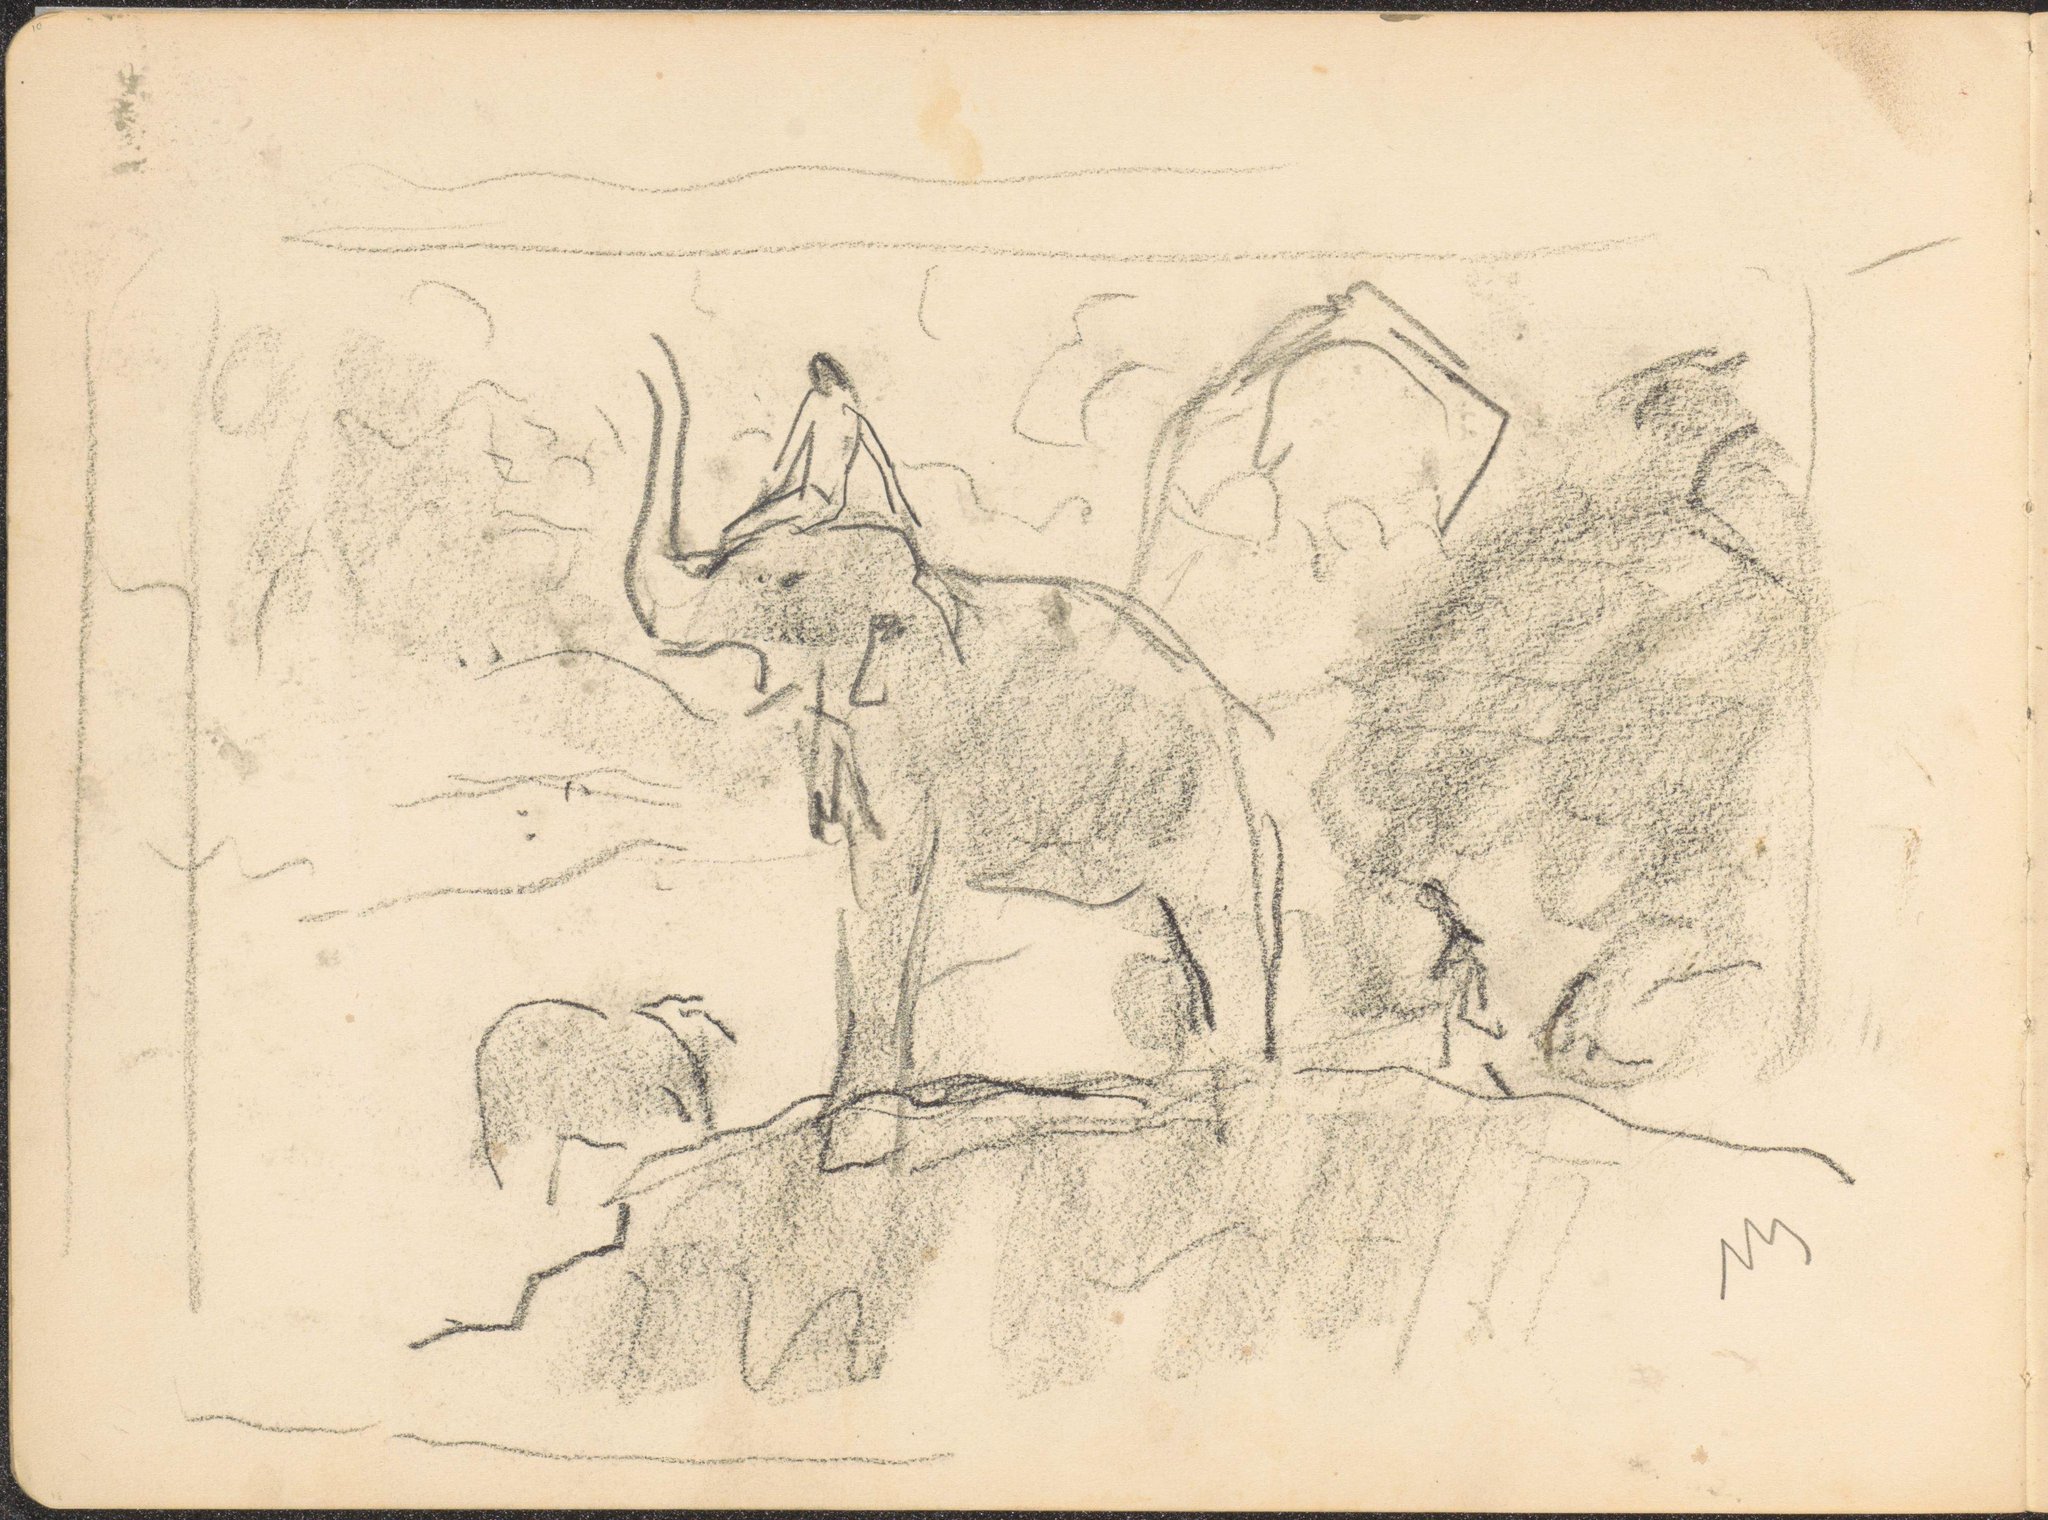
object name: sketchbook leaf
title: Figuur op een olifant in het oerwoud van Ceylon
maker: marius bauer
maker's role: draughtsman, print maker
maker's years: 1867-1932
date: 1924-1925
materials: chalk, paper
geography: sri lanka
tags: sitting figure, jungle, trunked animals: elephant, sri lanka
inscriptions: monogram: ‘MB’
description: Pagina 10 uit een schetsboek met 20 bladen.